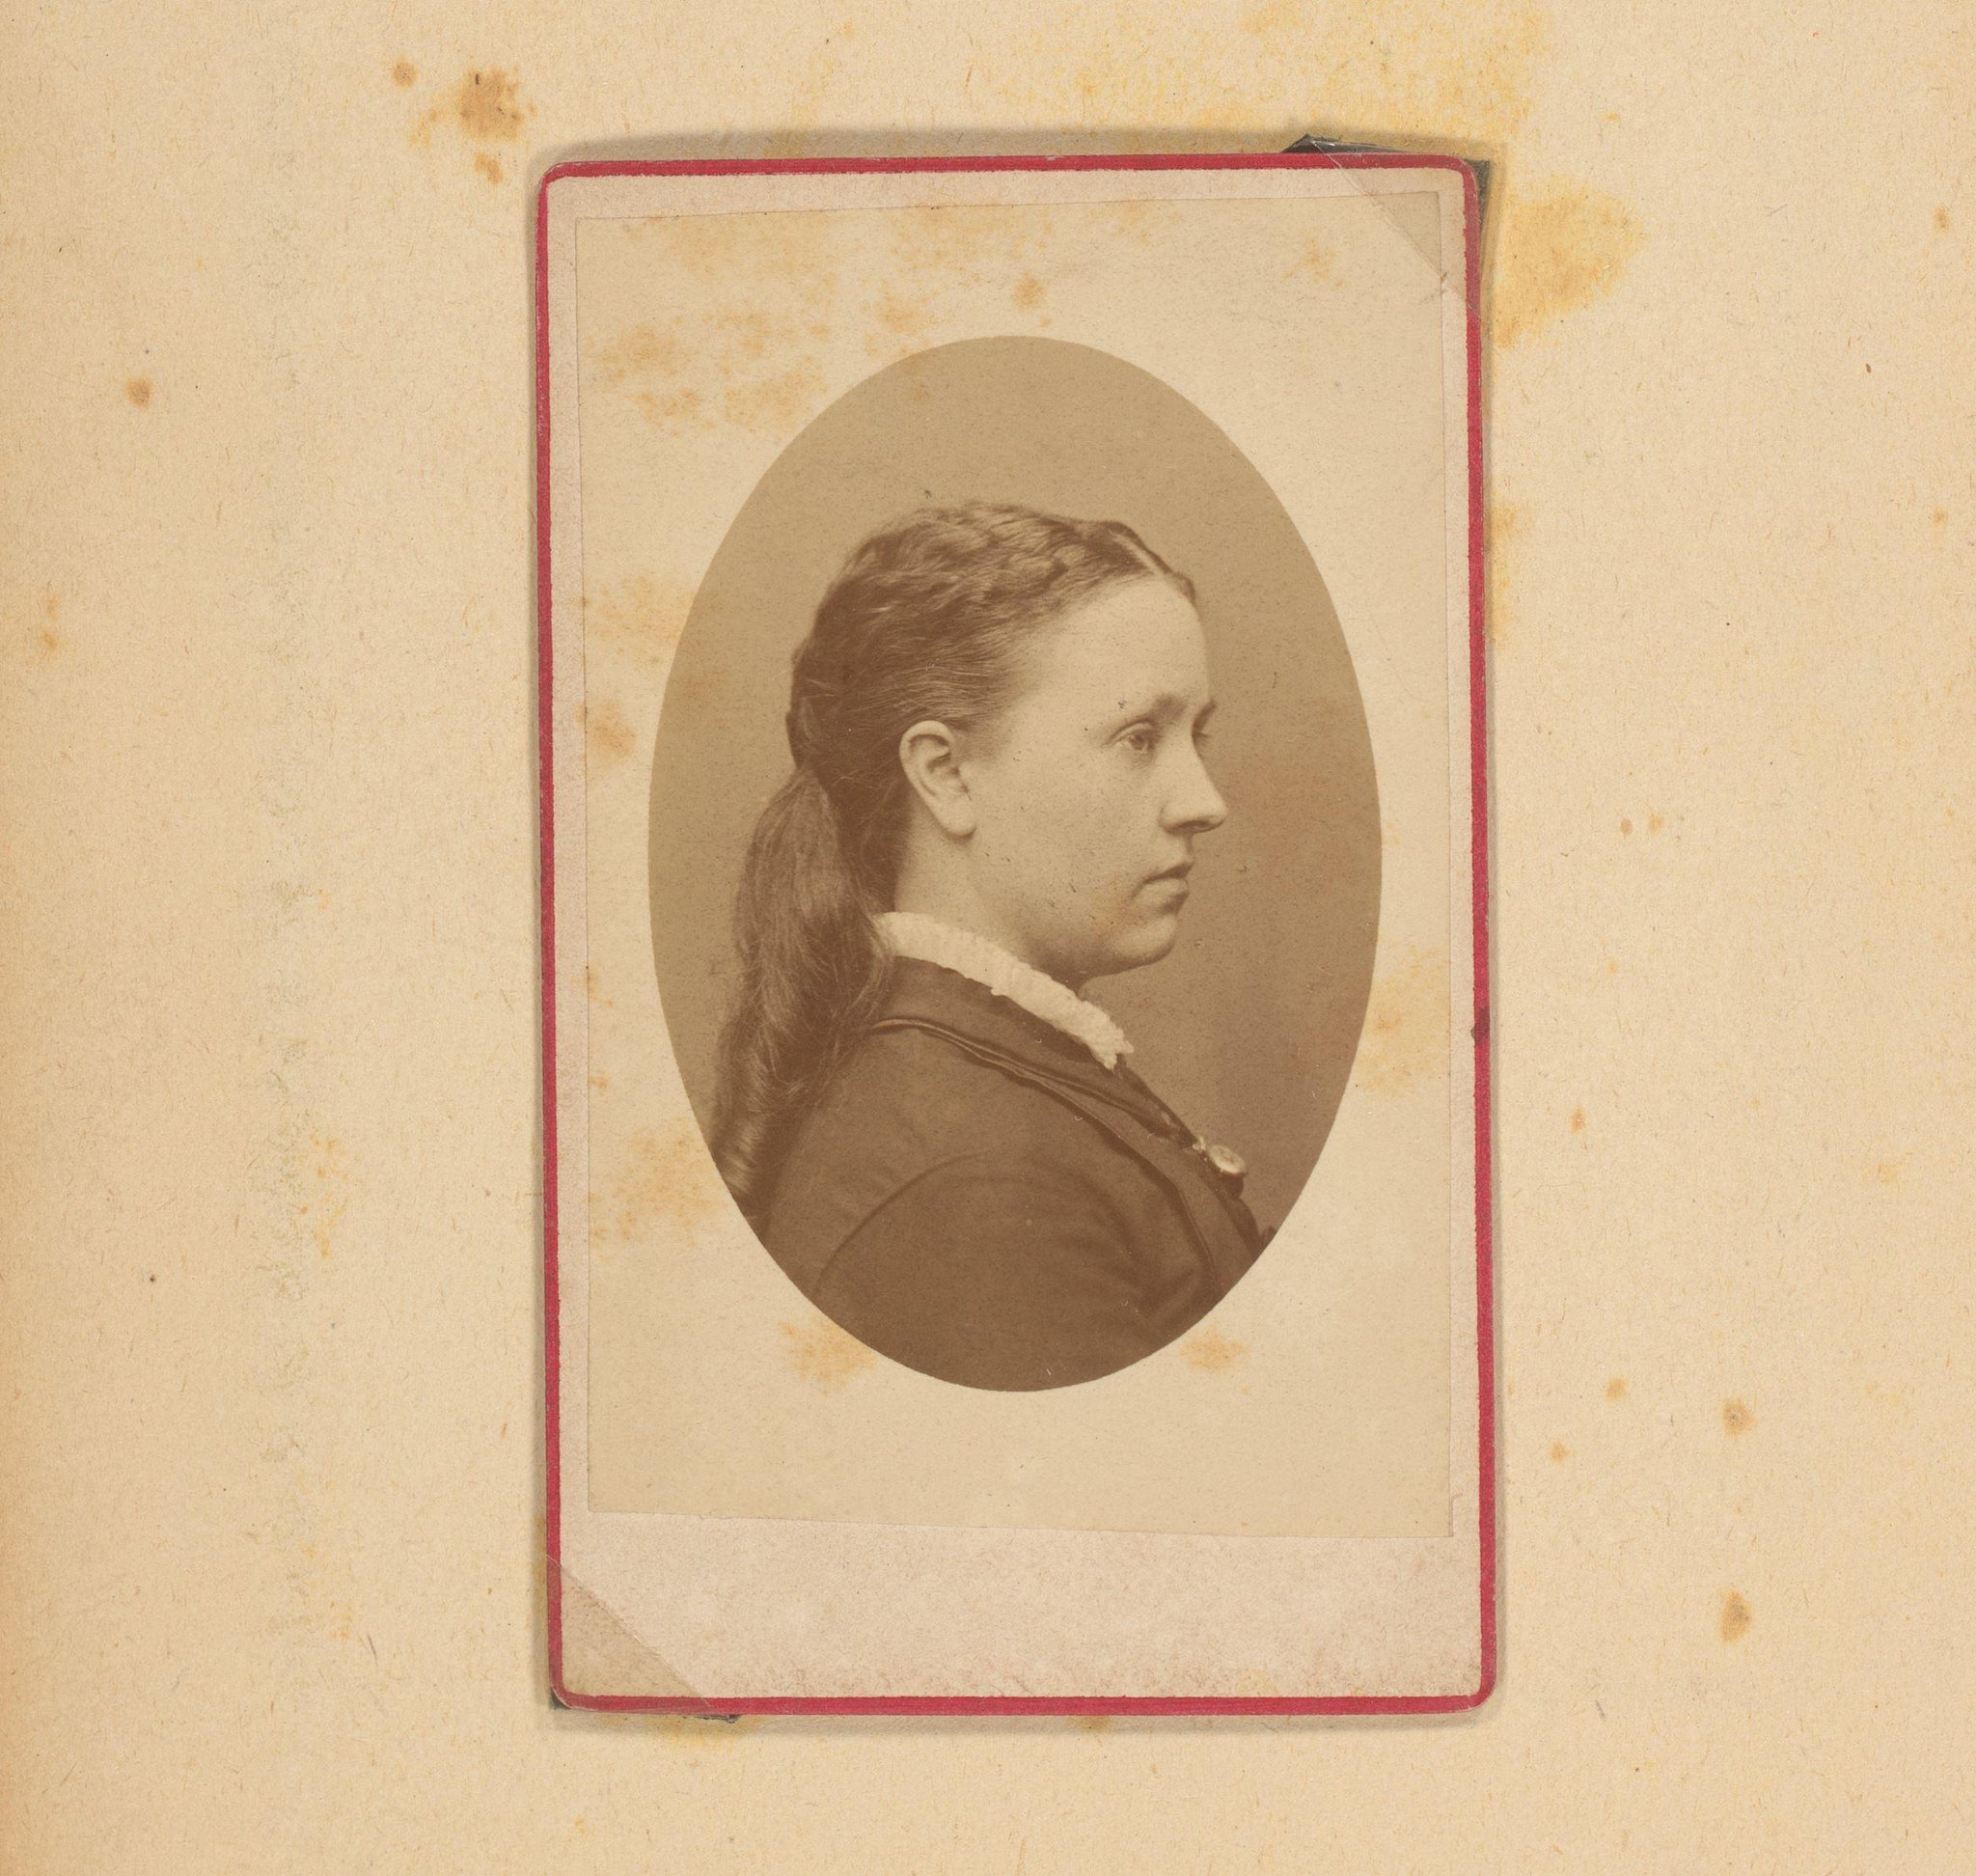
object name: photograph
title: Portret van een jonge vrouw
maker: Anonymous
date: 1860-1900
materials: cardboard, photographic support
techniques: albumen print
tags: adolescent, young woman, maiden, historical persons - bb - woman